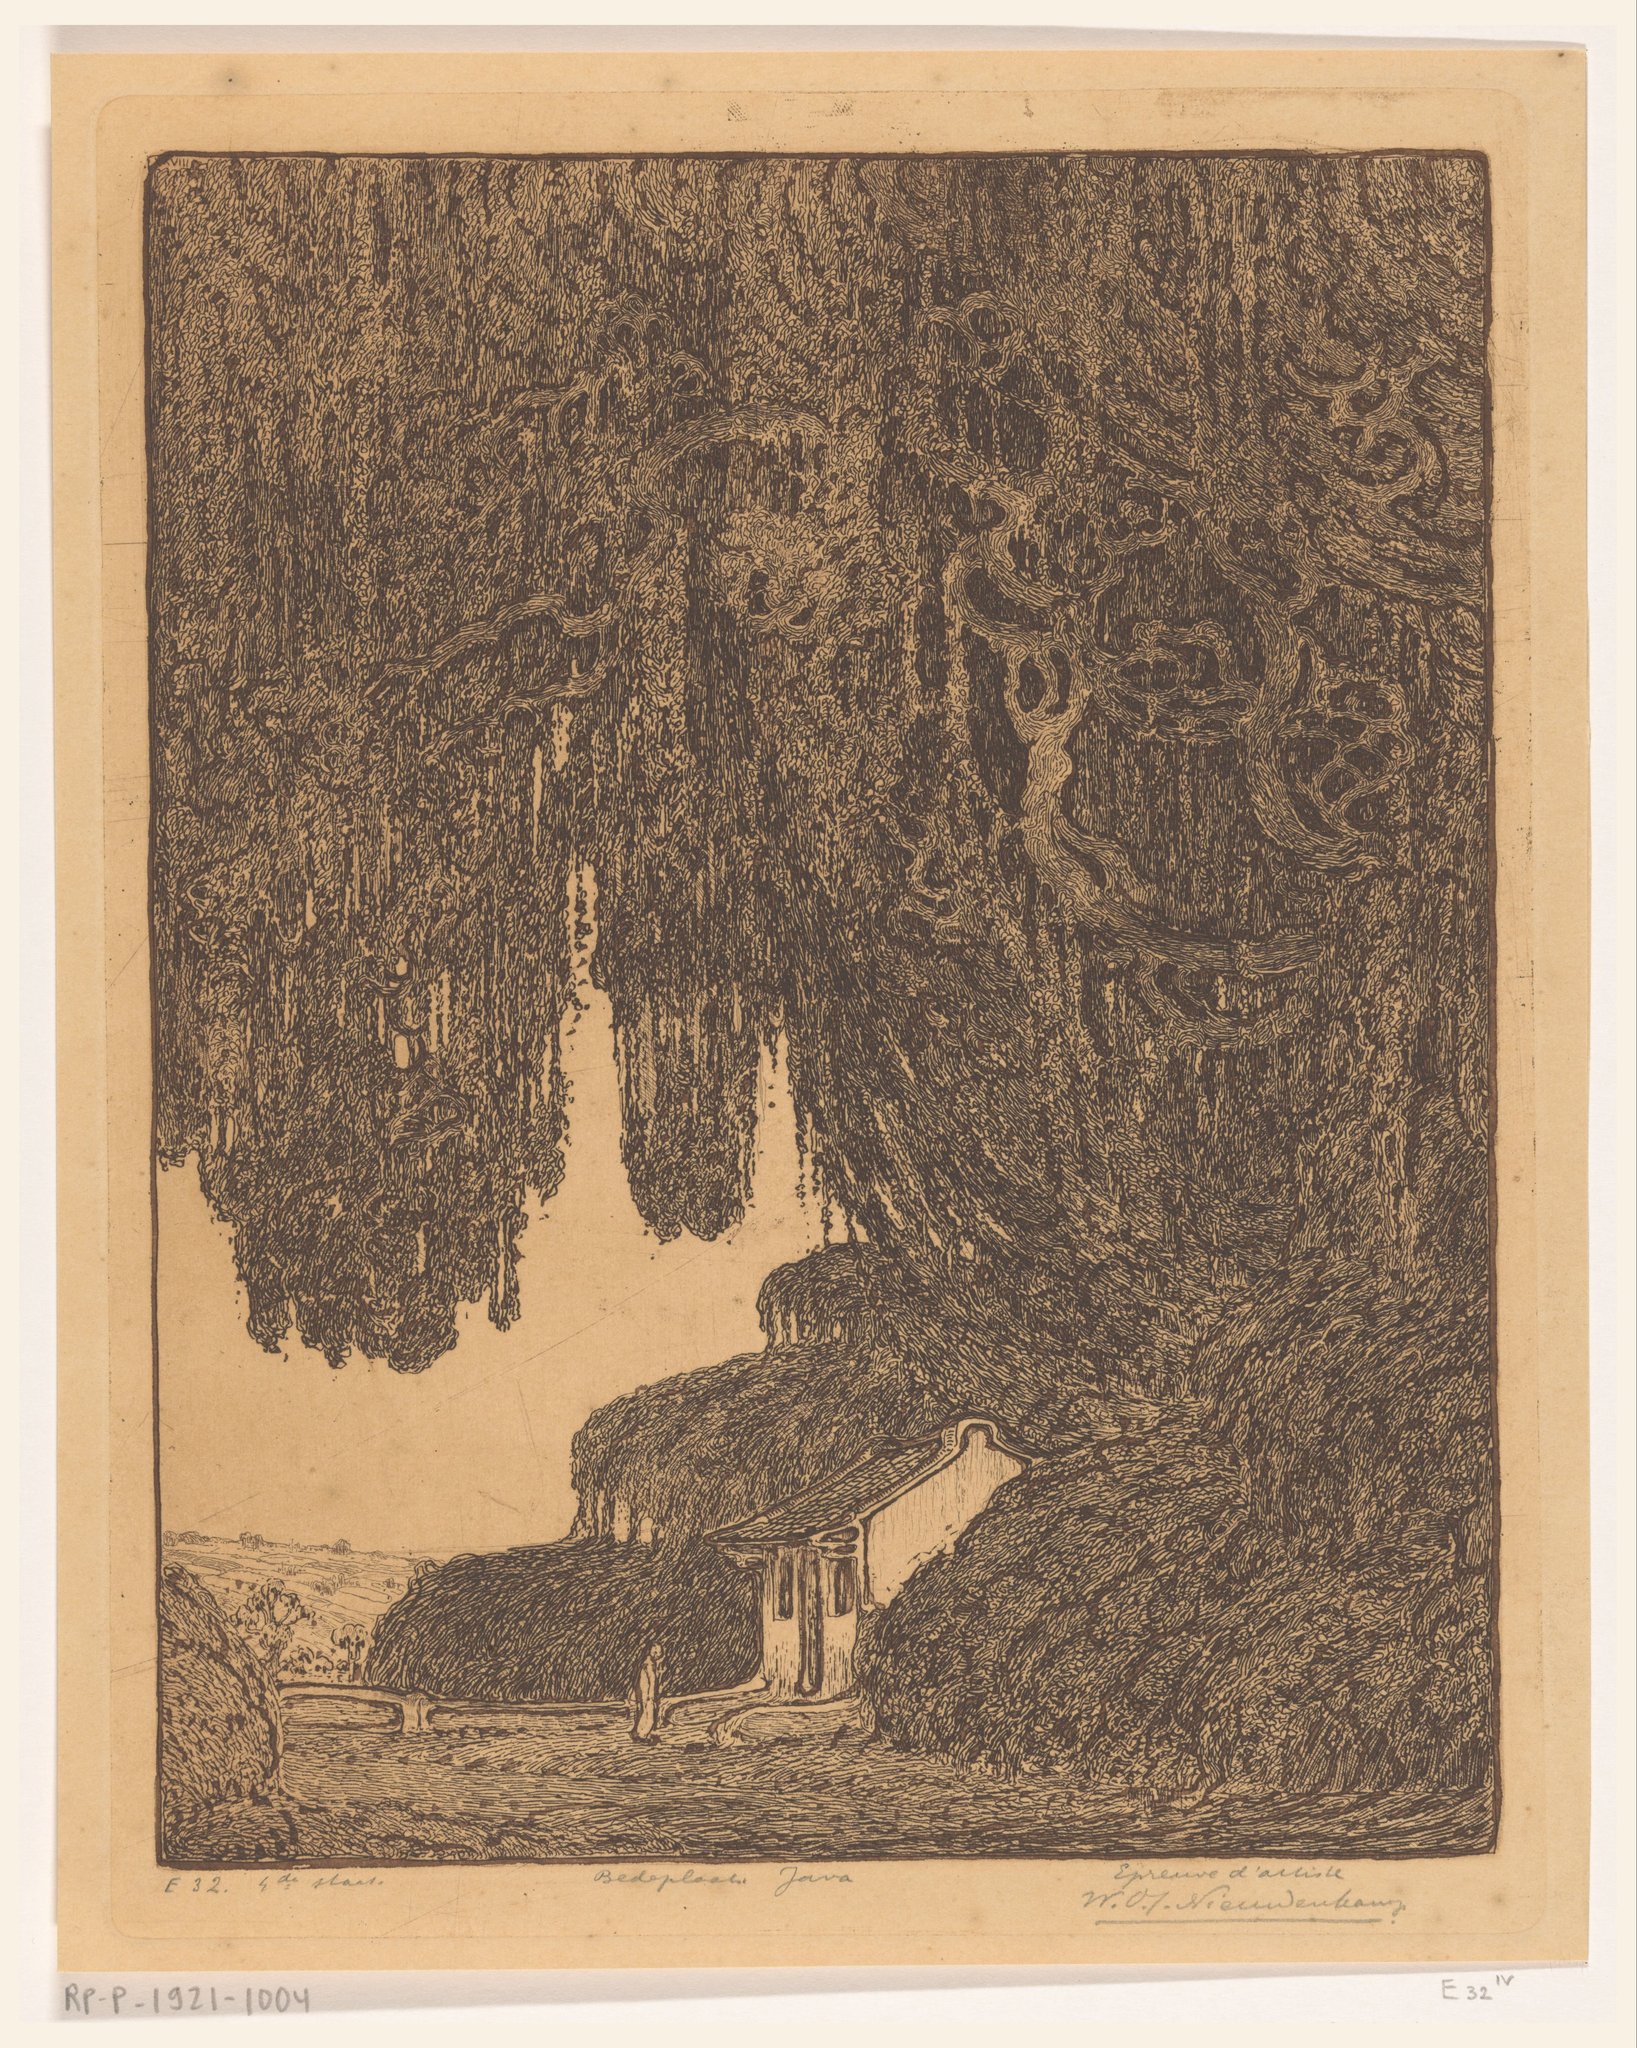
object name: print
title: Chinese kapel in de omgeving van Semarang op Java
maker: wijnand otto jan nieuwenkamp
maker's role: draughtsman, print maker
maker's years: 1874-1950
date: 1898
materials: paper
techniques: intaglio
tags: temple, shrine ~ hinduism, buddhism, jainism, trees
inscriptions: collector's mark: Lugt 2233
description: Naast de kapel groeit een boom die met klimplanten is begroeid.